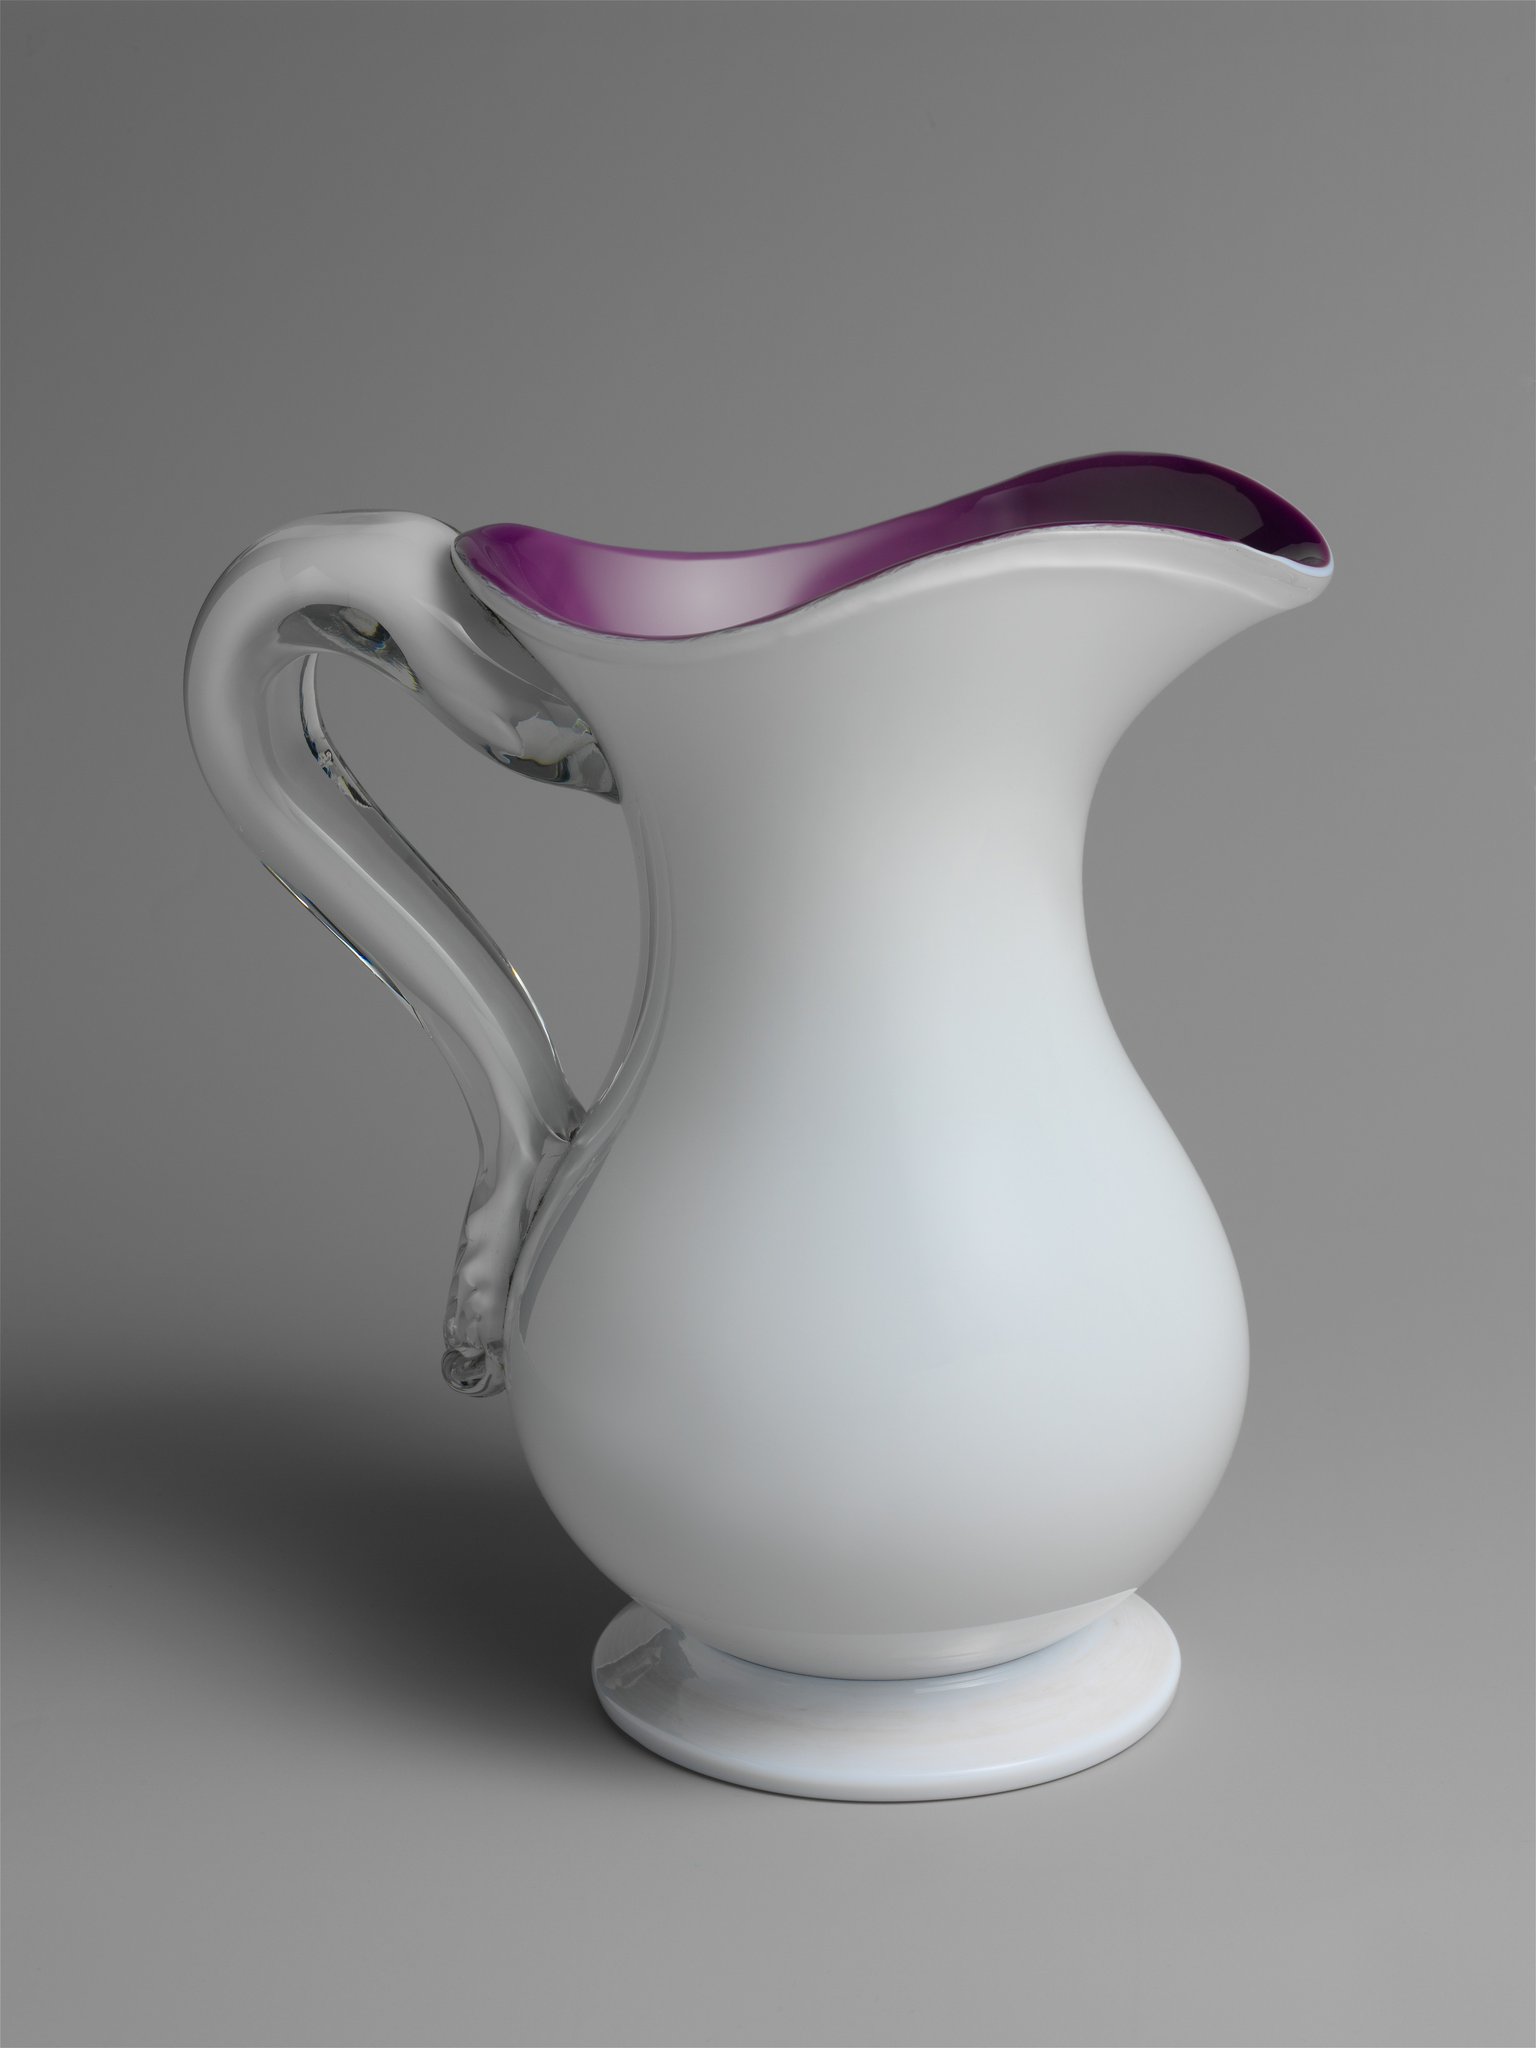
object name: pitcher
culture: american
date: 1850-1870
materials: glass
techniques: glassblowing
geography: united states